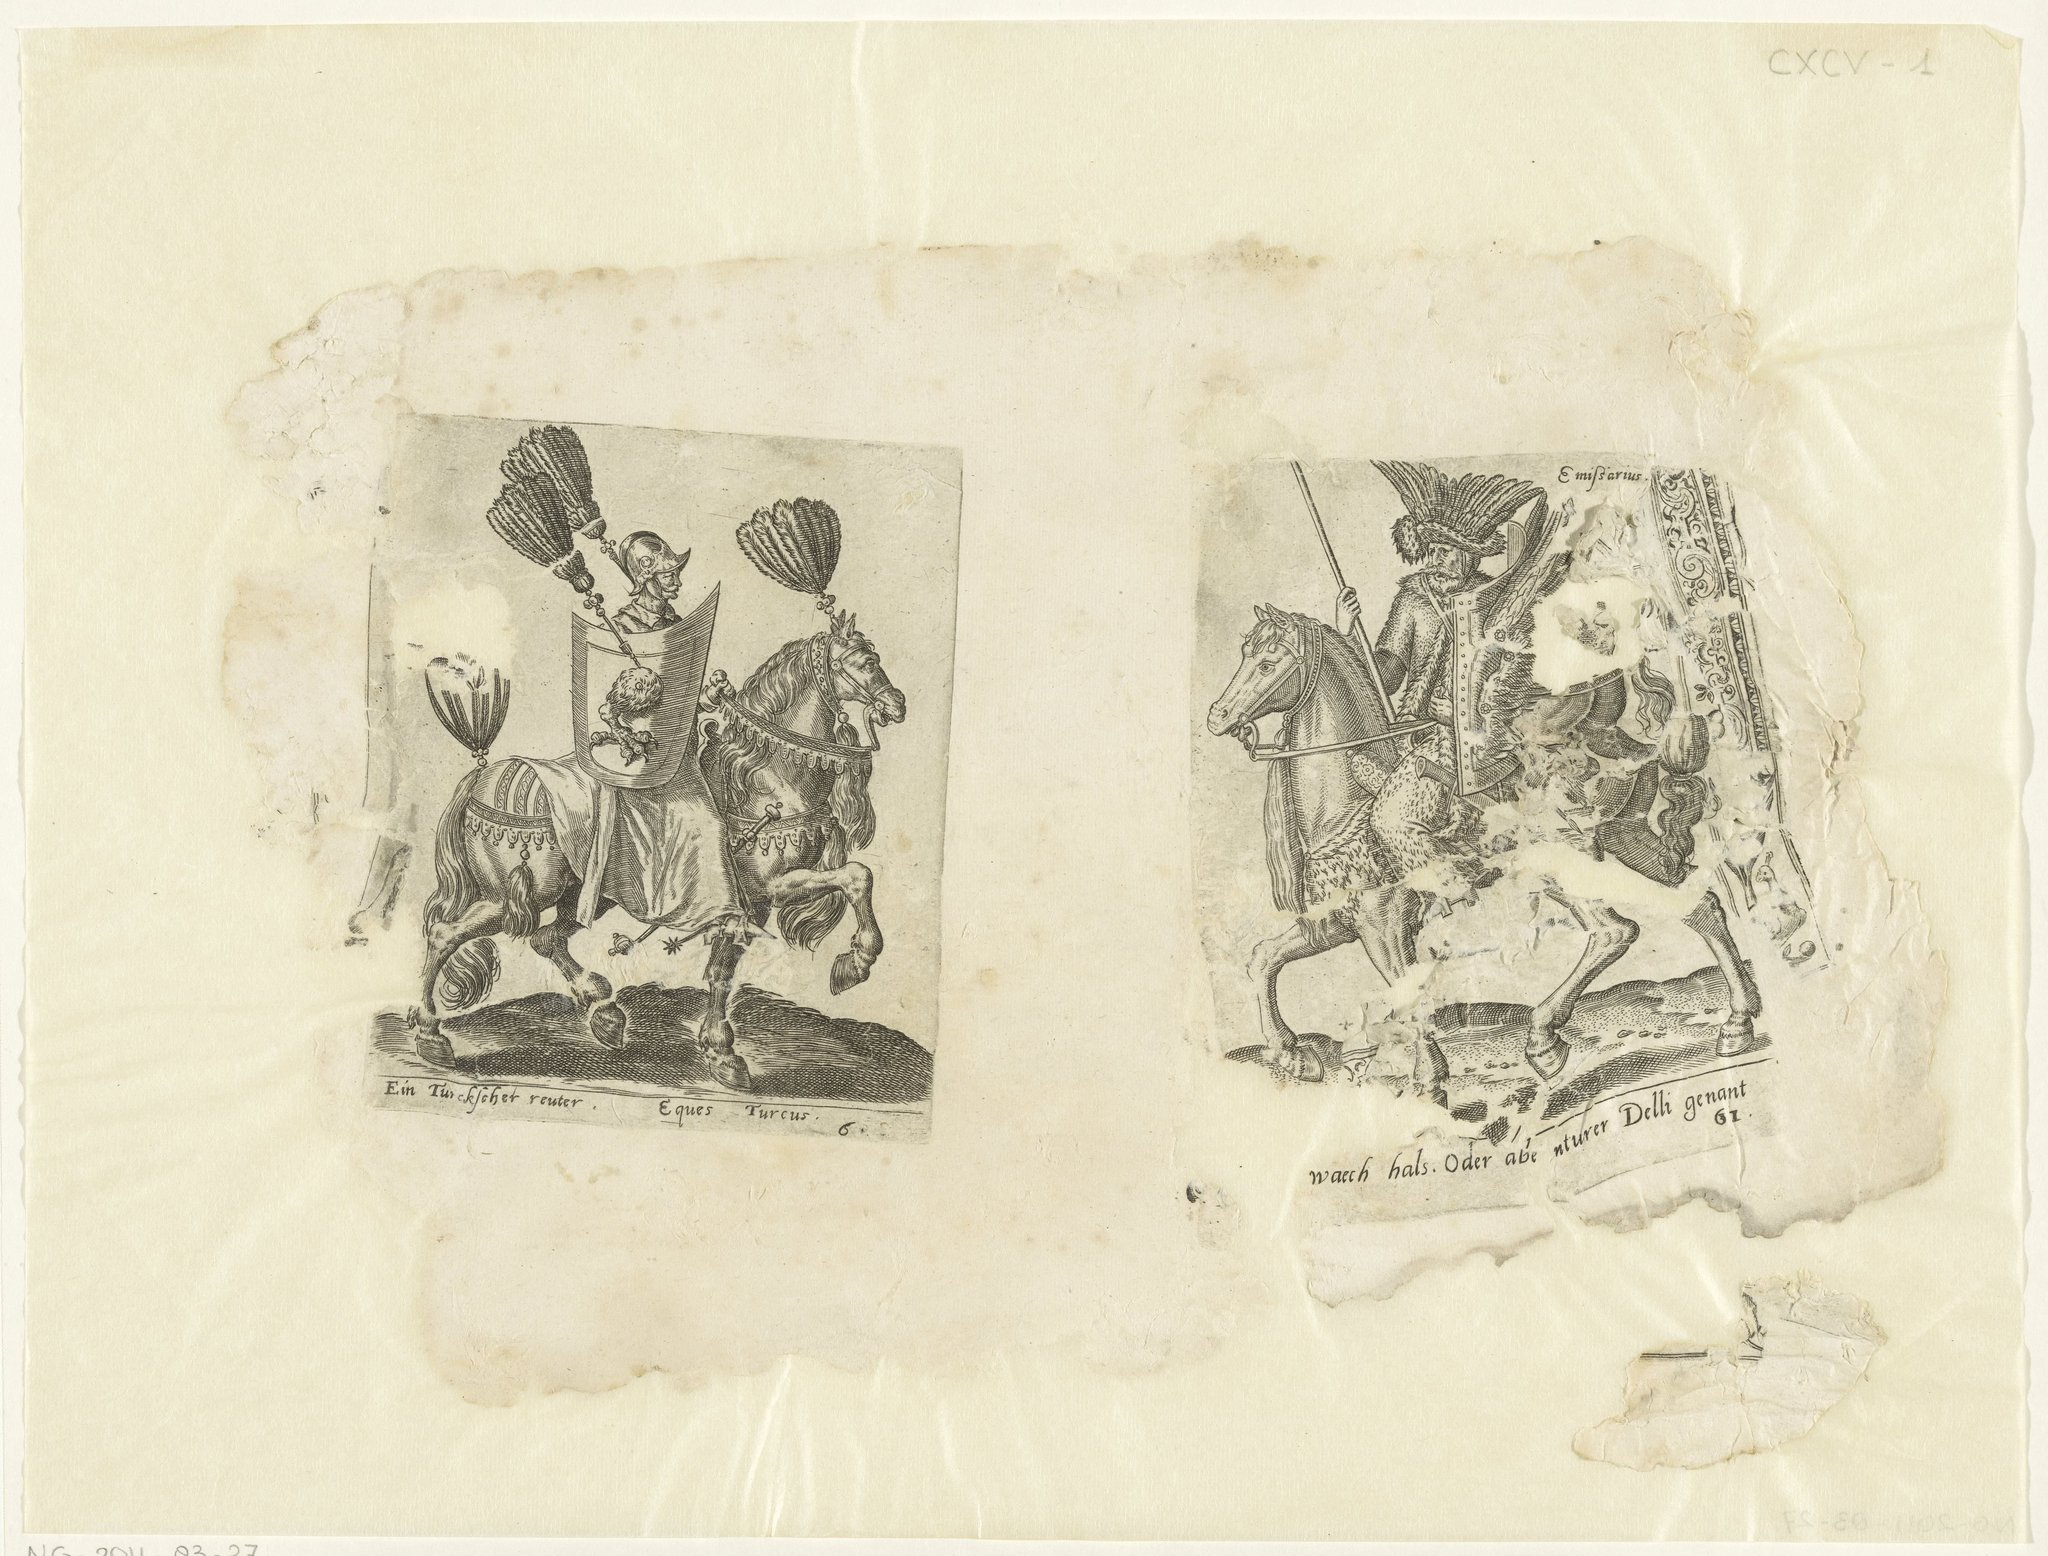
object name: print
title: Ottomaanse ruiter en avonturier te paard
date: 1576-1596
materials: paper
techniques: engraving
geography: cologne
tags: warfare; military affairs (+ cavalry, horsemen), folk costume, regional costume, military clothing and other equipment (uniforms, cap, armour, helmet, etc.)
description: Prent 48 en 49 uit een serie van 77, mogelijke serietitel Diversarum gentium armatura Equestris. Latere editie van serie Equitum Descripcio, Quomodo Equestres (...). De prenten in de Nova Zembla collectie zijn tijdens een expeditie van Willem Barendsz en Jacob van Heemskerk in 1596-1597 noodgedwongen in het winterkamp, het ‘Behouden Huis’, op het eiland achtergelaten. De prenten waren in één of meerdere stapels als handelswaar meegenomen vanuit Amsterdam. Bijna drie eeuwen later, in 1871, keerde de Noor Elling Carlsen terug naar Nova Zembla en vond daar de restanten van het ‘Behouden Huis, inclusief een groot deel van de inventaris. Een deel van de prenten, in de vorm van aaneengekoekte kluiten, werd toen ook teruggevonden. De papierkluiten waren soms op meerdere plekken gebroken. Tussen 1975-1979 zijn de prenten van elkaar gescheiden. Dit leverde in totaal ca. 1000 fragmenten van ca. 400 afdrukken van ca. 150 verschillende prenten op. Voor zover mogelijk zijn de fragmenten samengevoegd en zijn de prenten gereconstrueerd.